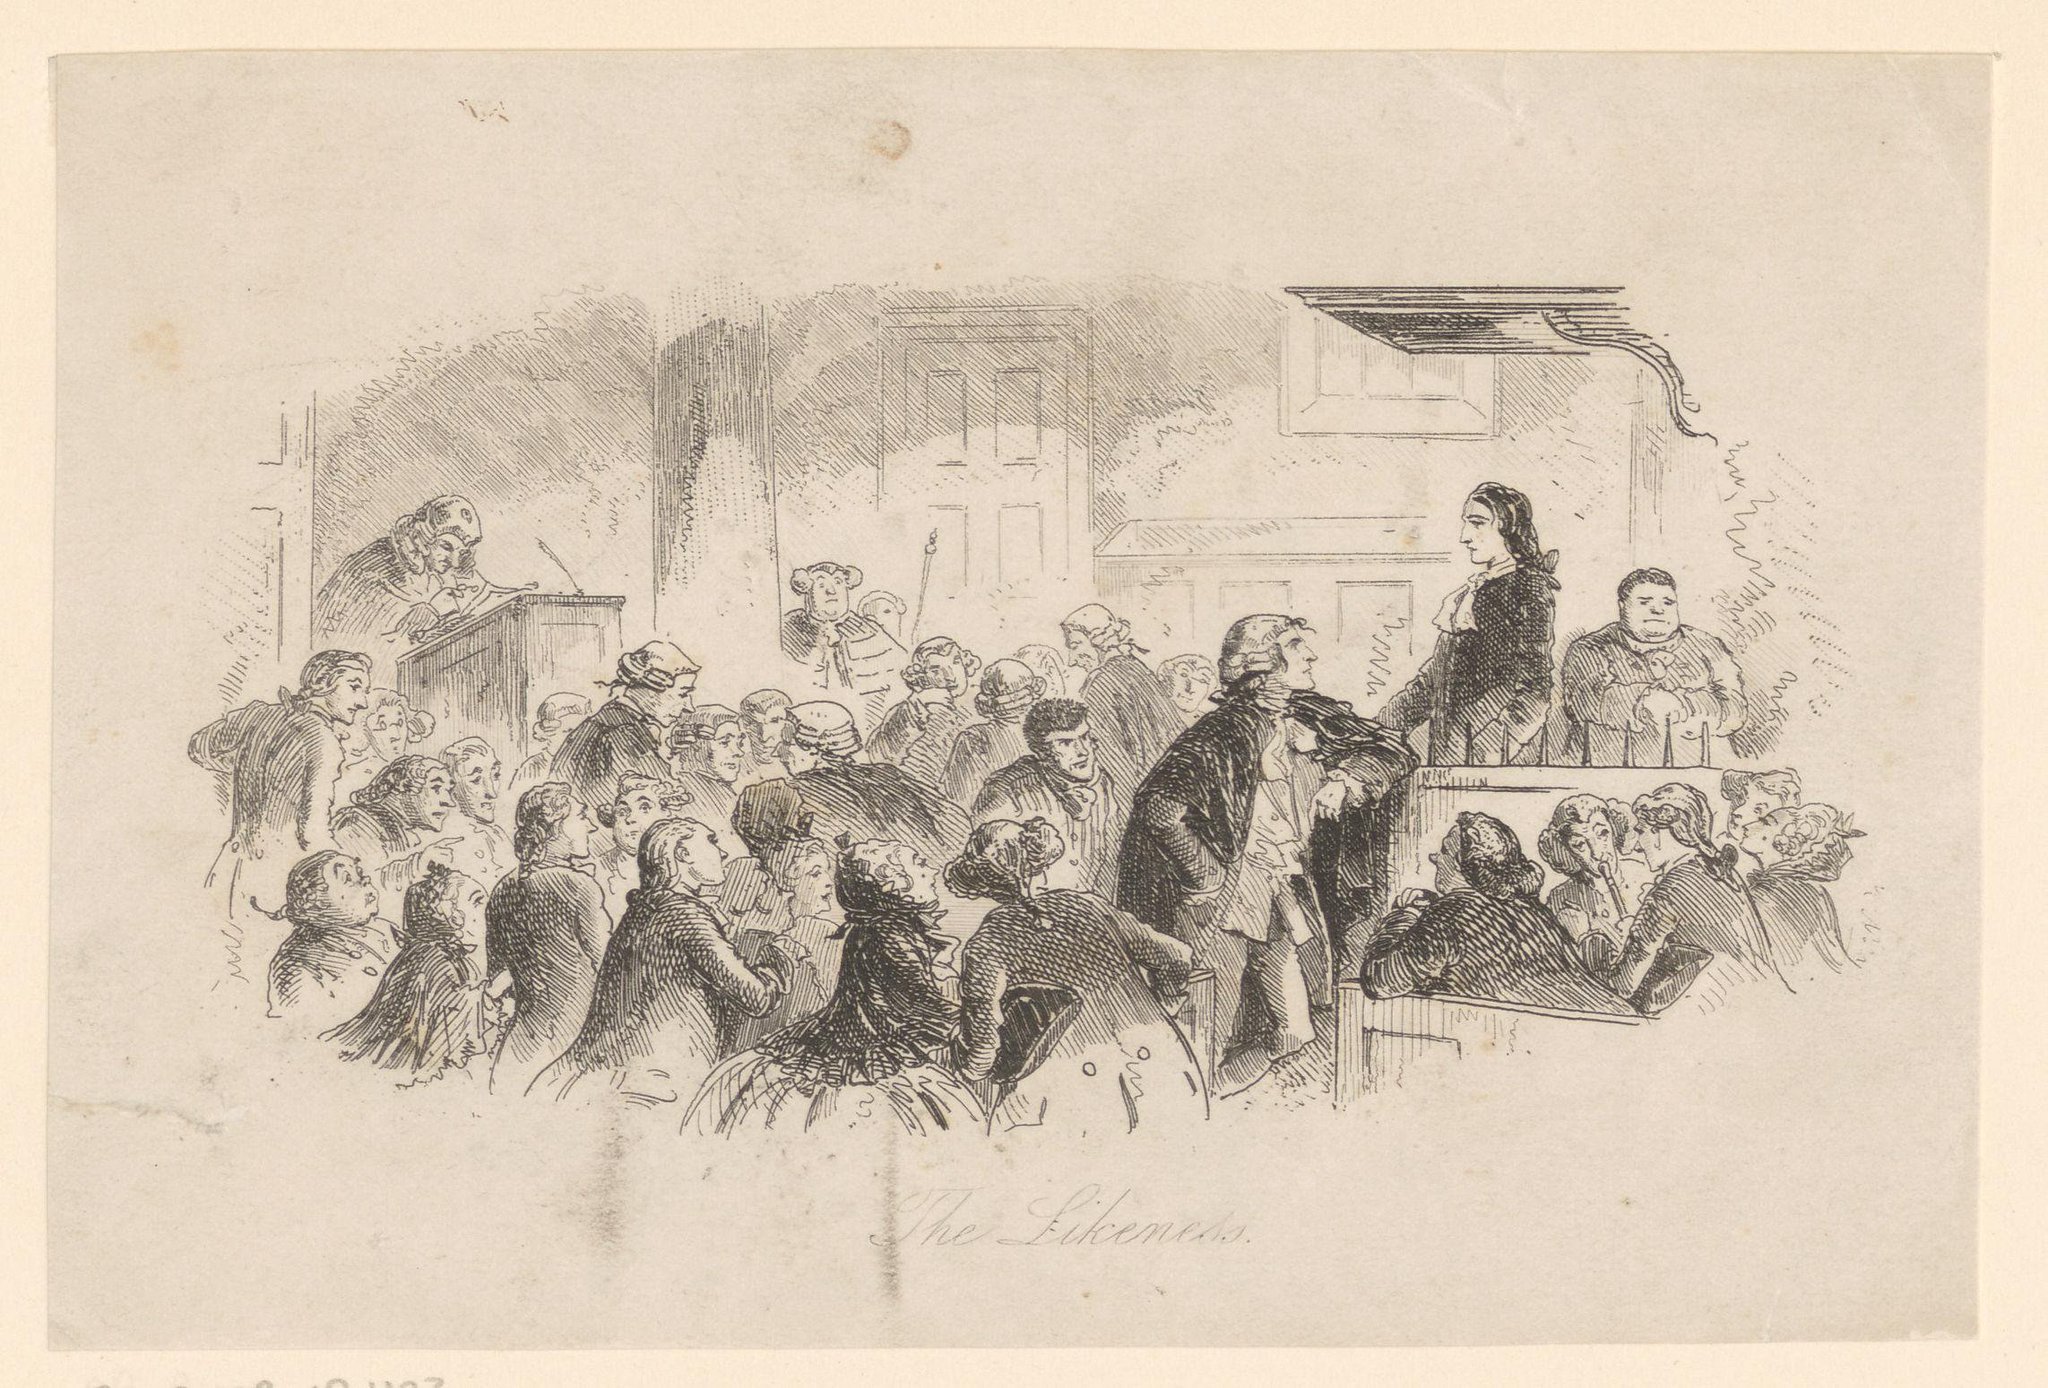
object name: book illustration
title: Menigte in een rechtbank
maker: hablot knight browne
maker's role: print maker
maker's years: 1815-1882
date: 1859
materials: paper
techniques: etching, roulette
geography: london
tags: court-room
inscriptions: collector's mark: Lugt 2228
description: Prent uit: Dickens, Charles. A Tale of Two Cities. Londen: Chapman and Hall, 1859. Het boek werd van april tot november 1859 eerst in delen uitgegeven.